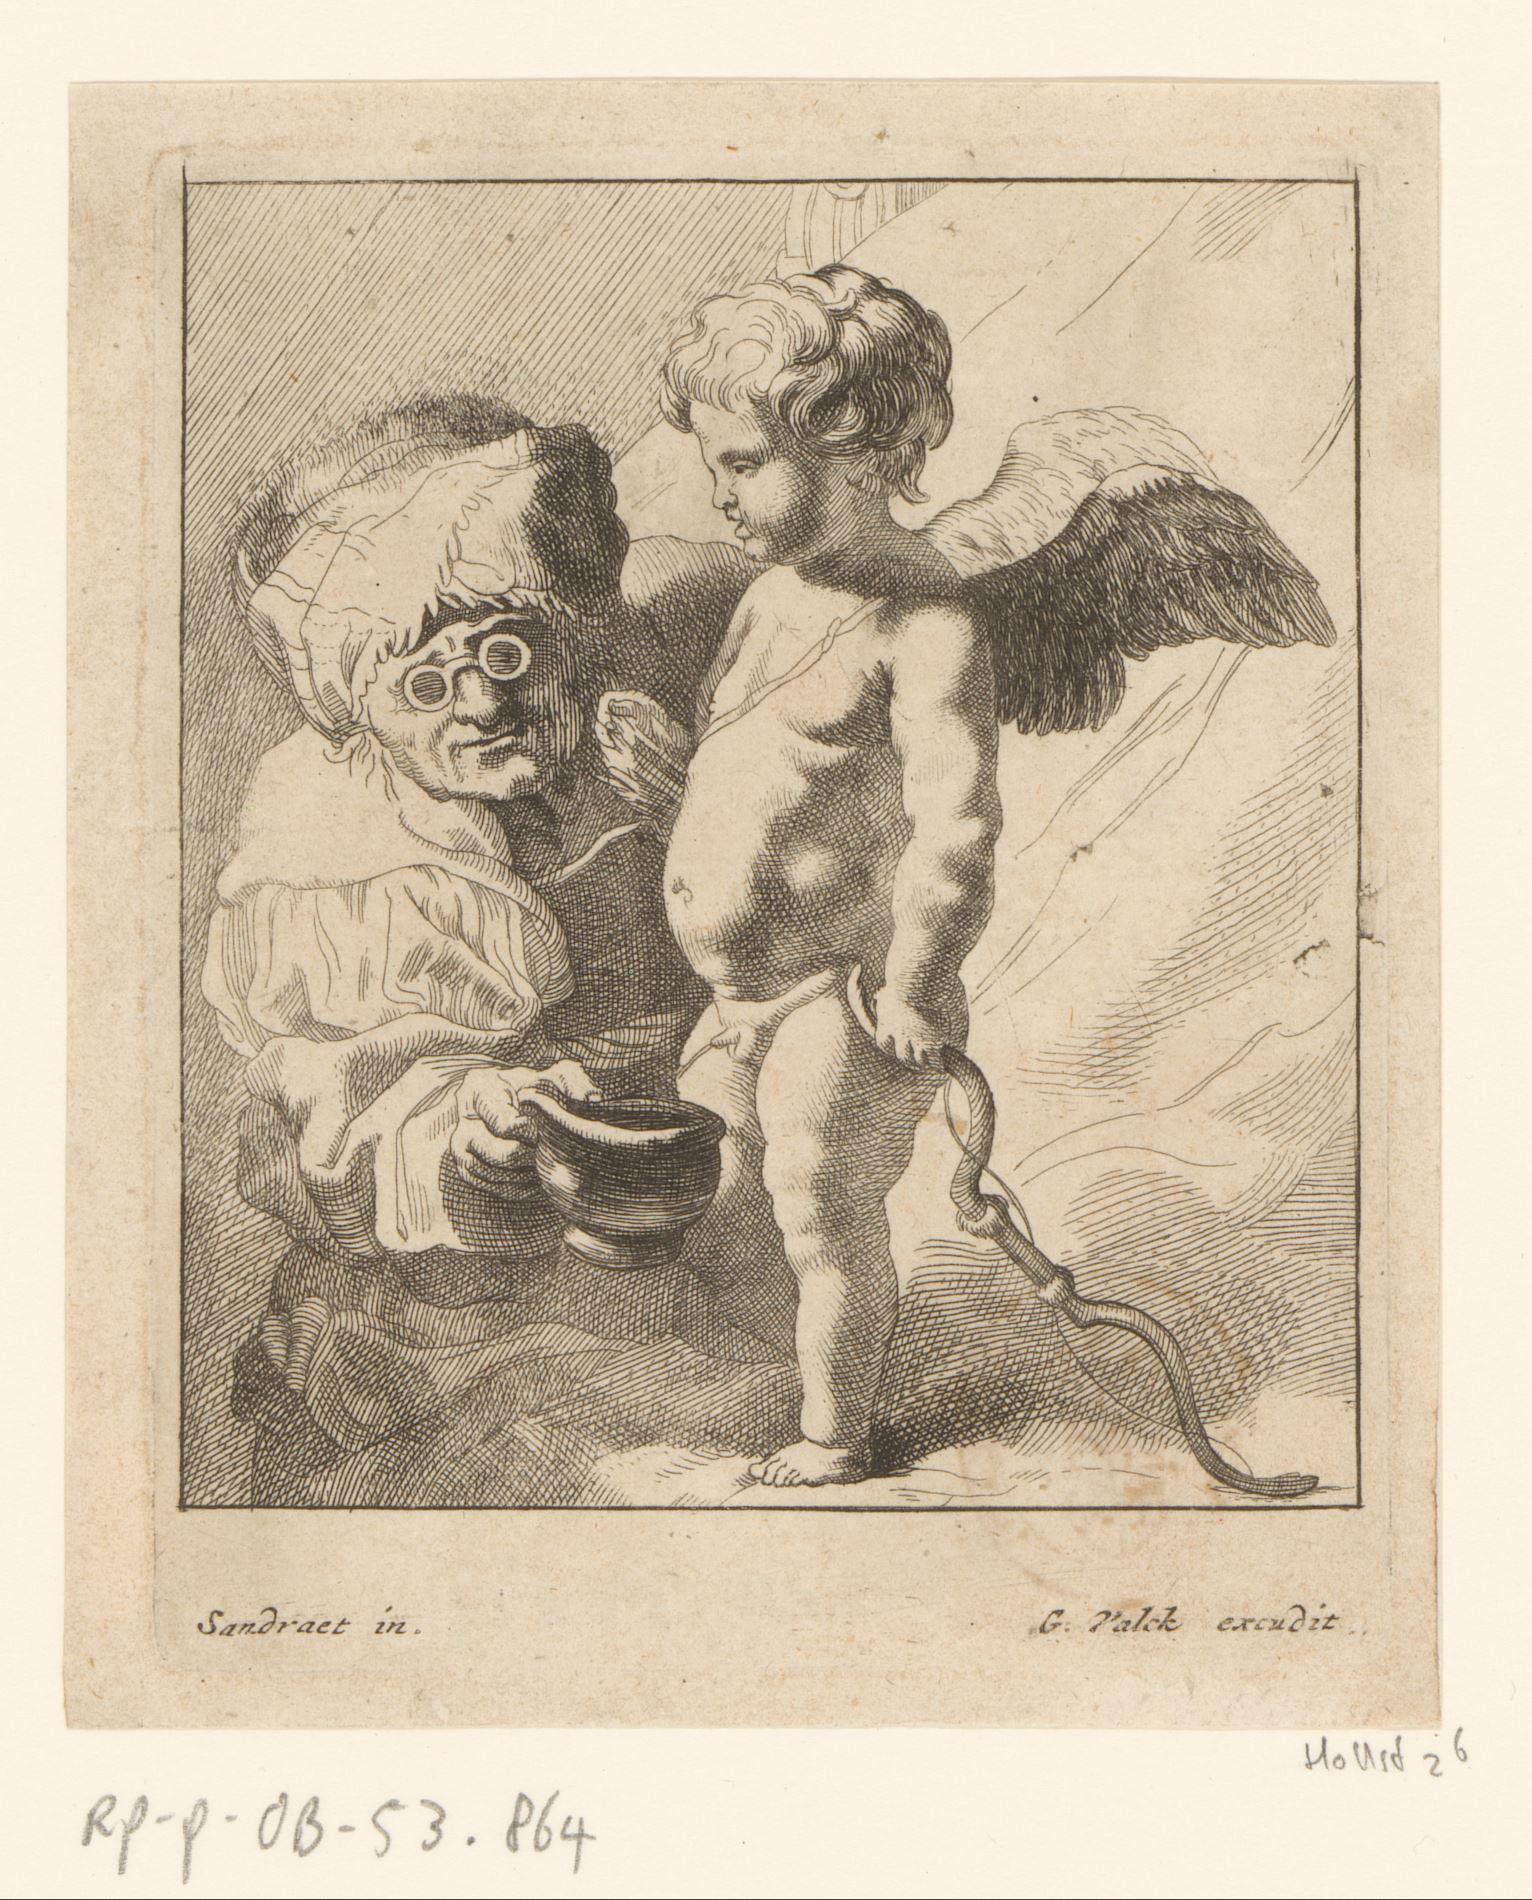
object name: print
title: Plas van Cupido wordt door een oude man opgevangen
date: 1661-1726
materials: paper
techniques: engraving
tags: old man, (story of) cupid, amor (eros), chamber-pot, urination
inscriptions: collector's mark: Lugt 240